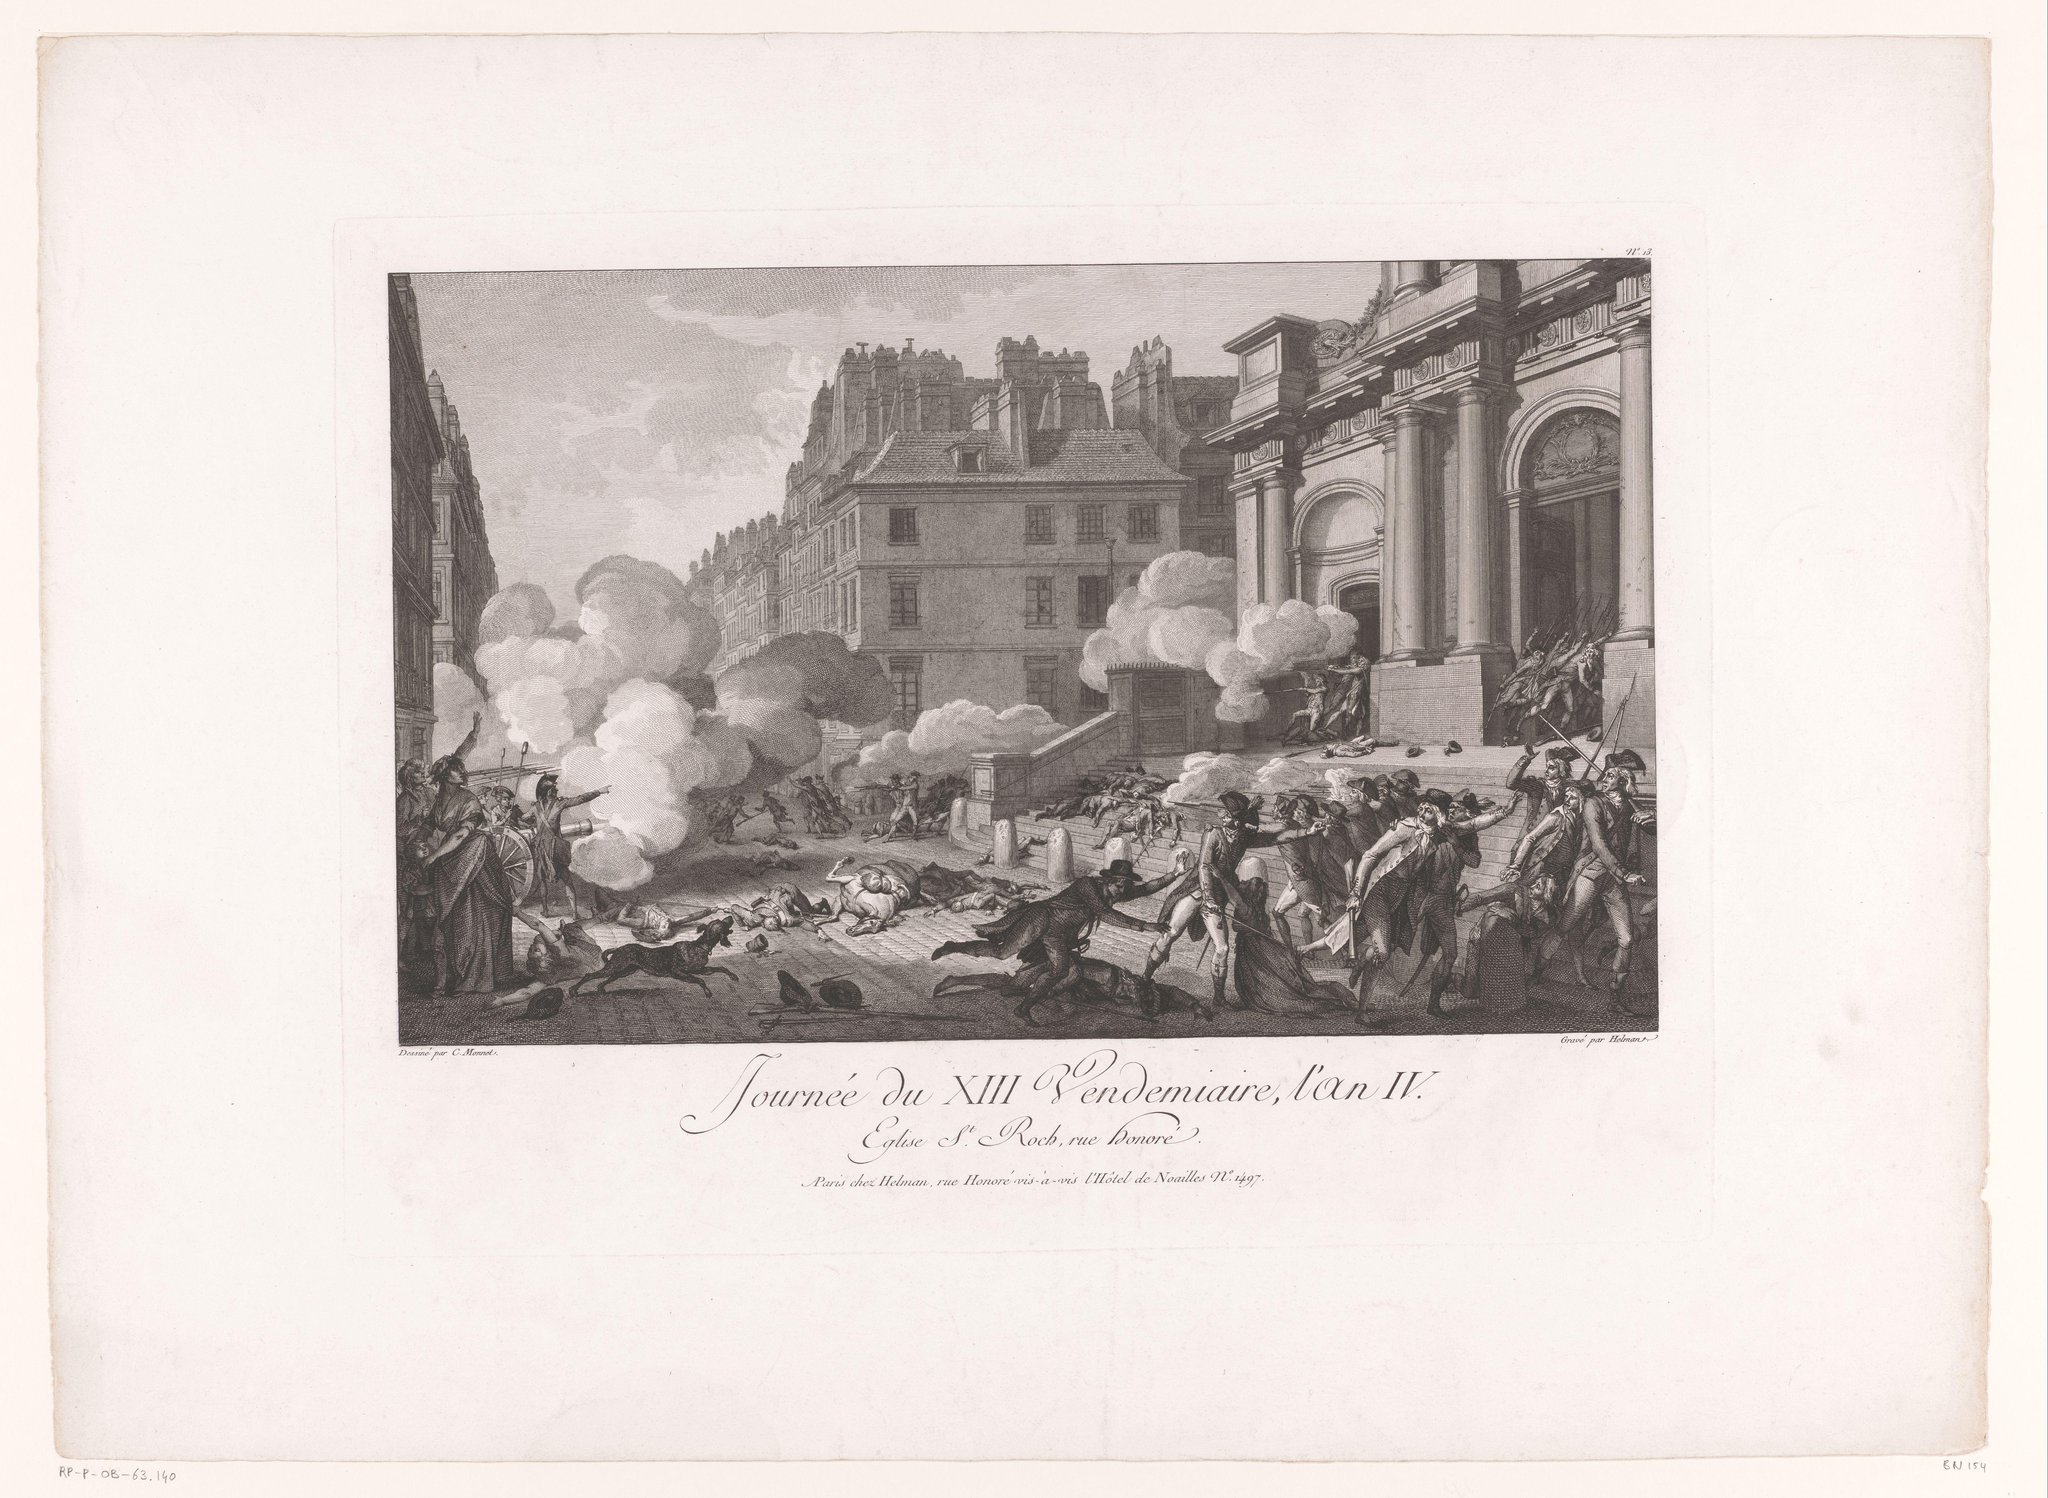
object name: print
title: Les principales journées de la Révolution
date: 1797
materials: paper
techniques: engraving, etching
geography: france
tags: church (exterior), firearms: cannon, revolution, revolt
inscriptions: collector's mark: Lugt 2228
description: Maakt deel uit van een serie getiteld 'La Révolution française depuis l'ouverture des États géneraux jusquáu 9 Brumaire' met vijftien prenten naar schilderijen met als onderwerp de eerste dagen van de Franse Revolutie. De serie werd verschillende malen uitgegeven, aanvankelijk onder de titel 'Les principales journées de la Révolution'. Voor meer informatie zie IFF 18e siècle, dl. 11, p. 291.